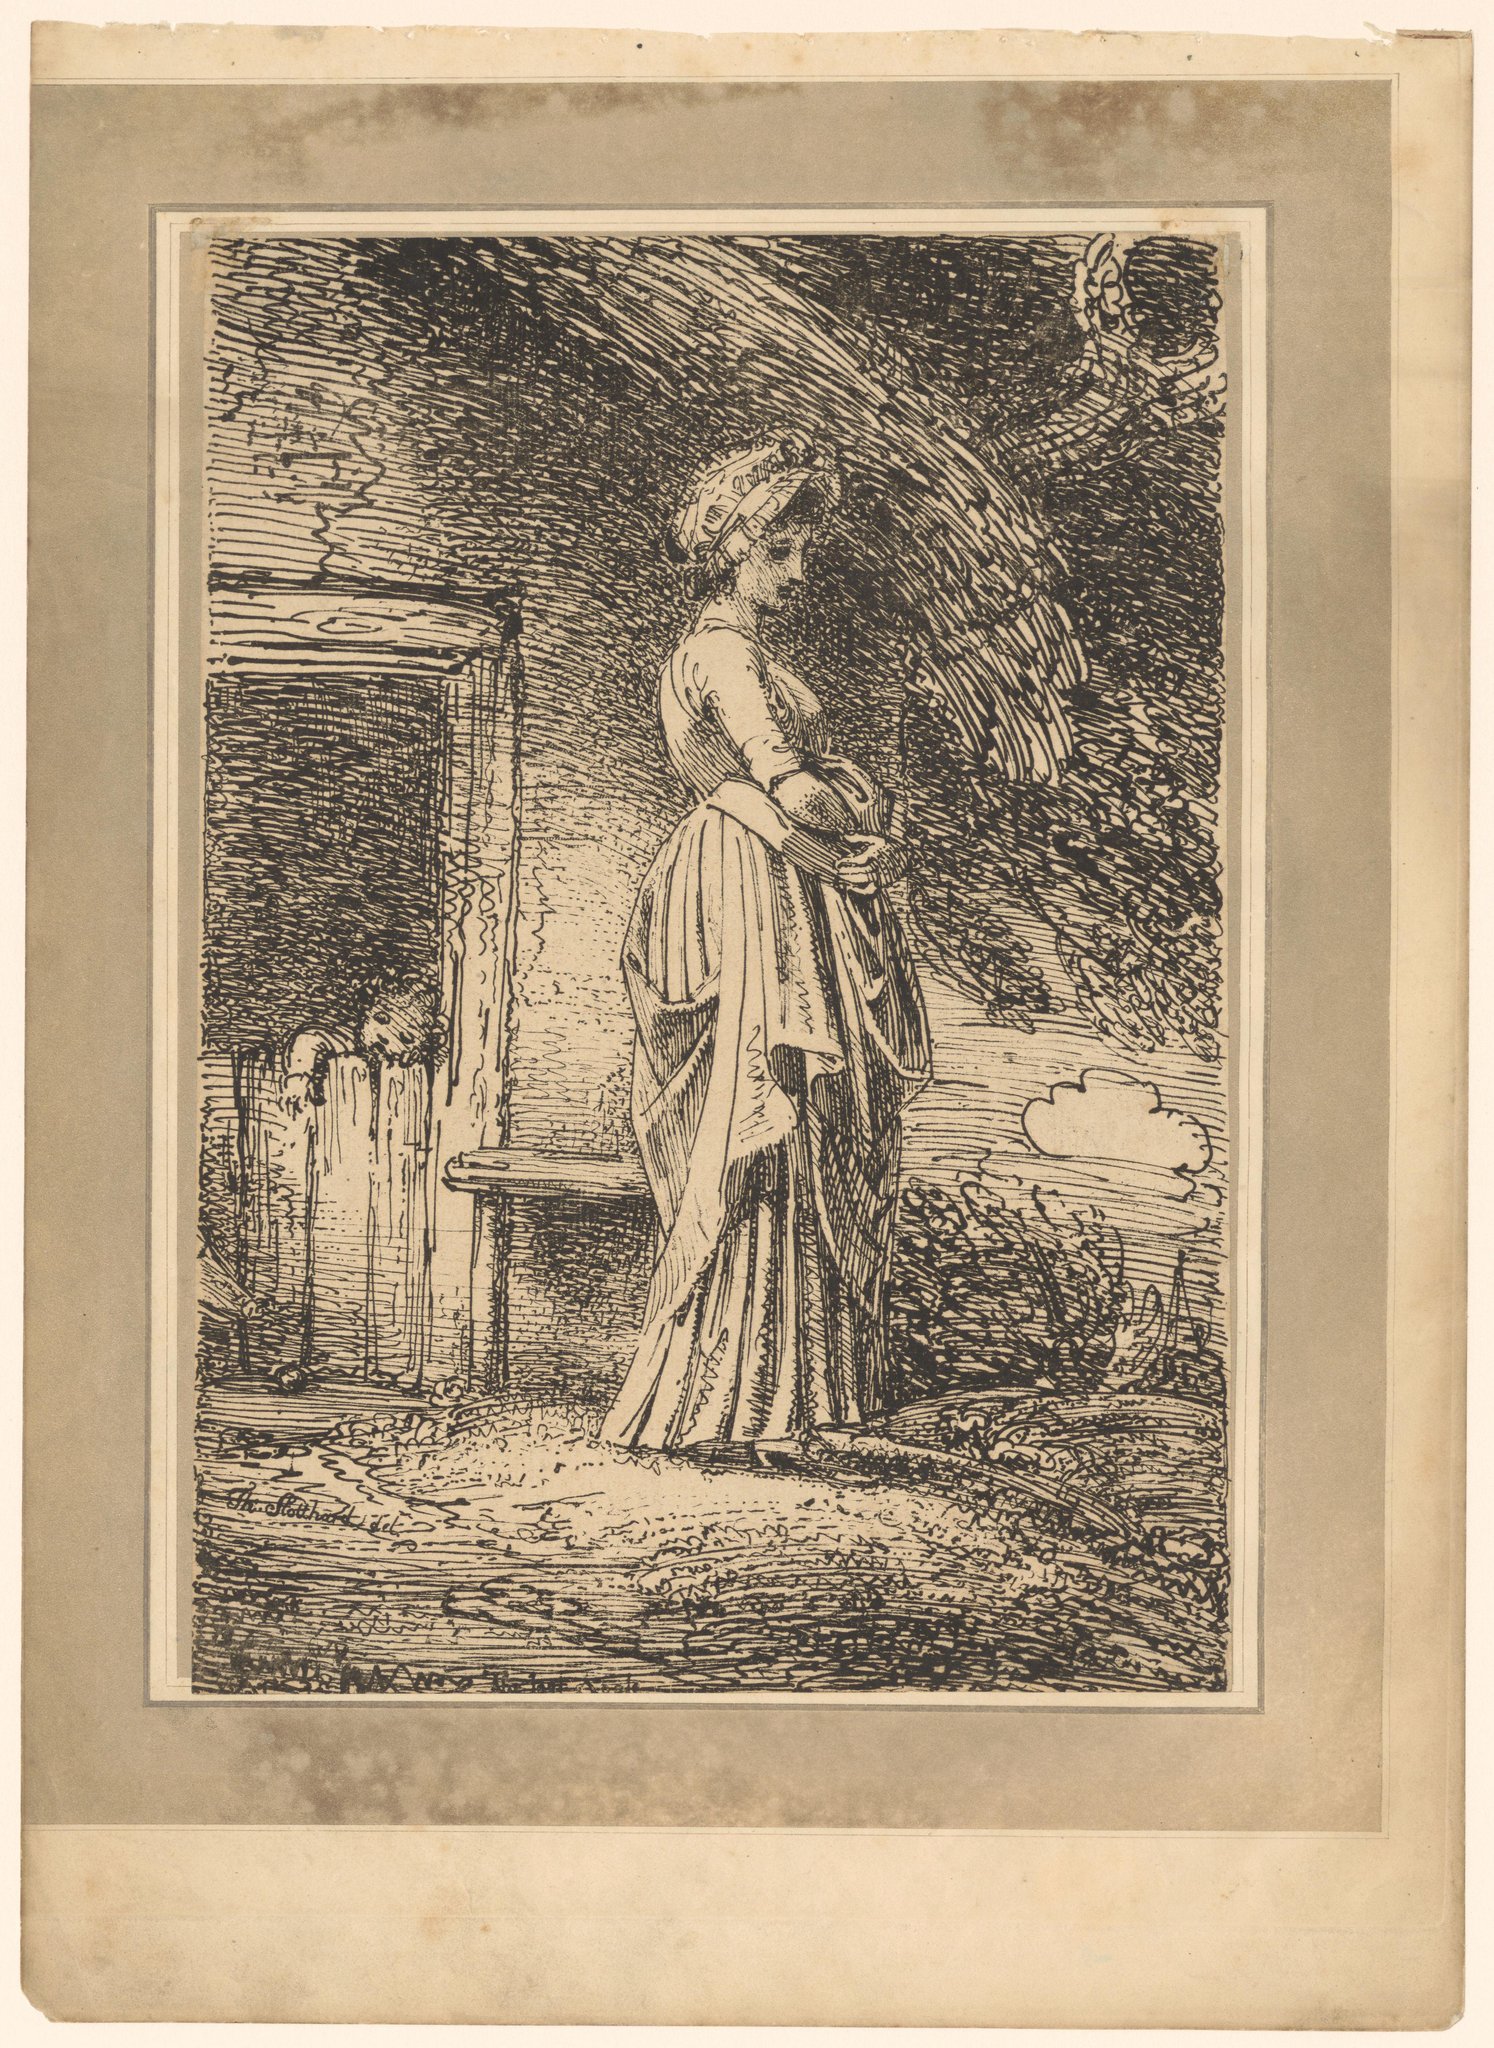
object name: print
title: Specimens of polyautography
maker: thomas stothard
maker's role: draughtsman, painter, print maker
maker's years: 1755-1834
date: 1803-1807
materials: paper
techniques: lithograph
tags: fruits: apple, cottage, mother and baby or young child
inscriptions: collector's mark: Lugt 2760, collector's mark: Lugt 2228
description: Deze prent behoort tot de serie 'Specimens of polyautography'. Deze serie is een van de vroegste reeksen lithografieën in Groot-Brittannië en de eerste editie werd uitgegeven door Philipp André in 1803. Een tweede editie is uitgegeven door Georg Jacob Vollweiler in 1806-1807. De serie is door Vollweiler uitgegeven in zes delen met zes lithografieën.